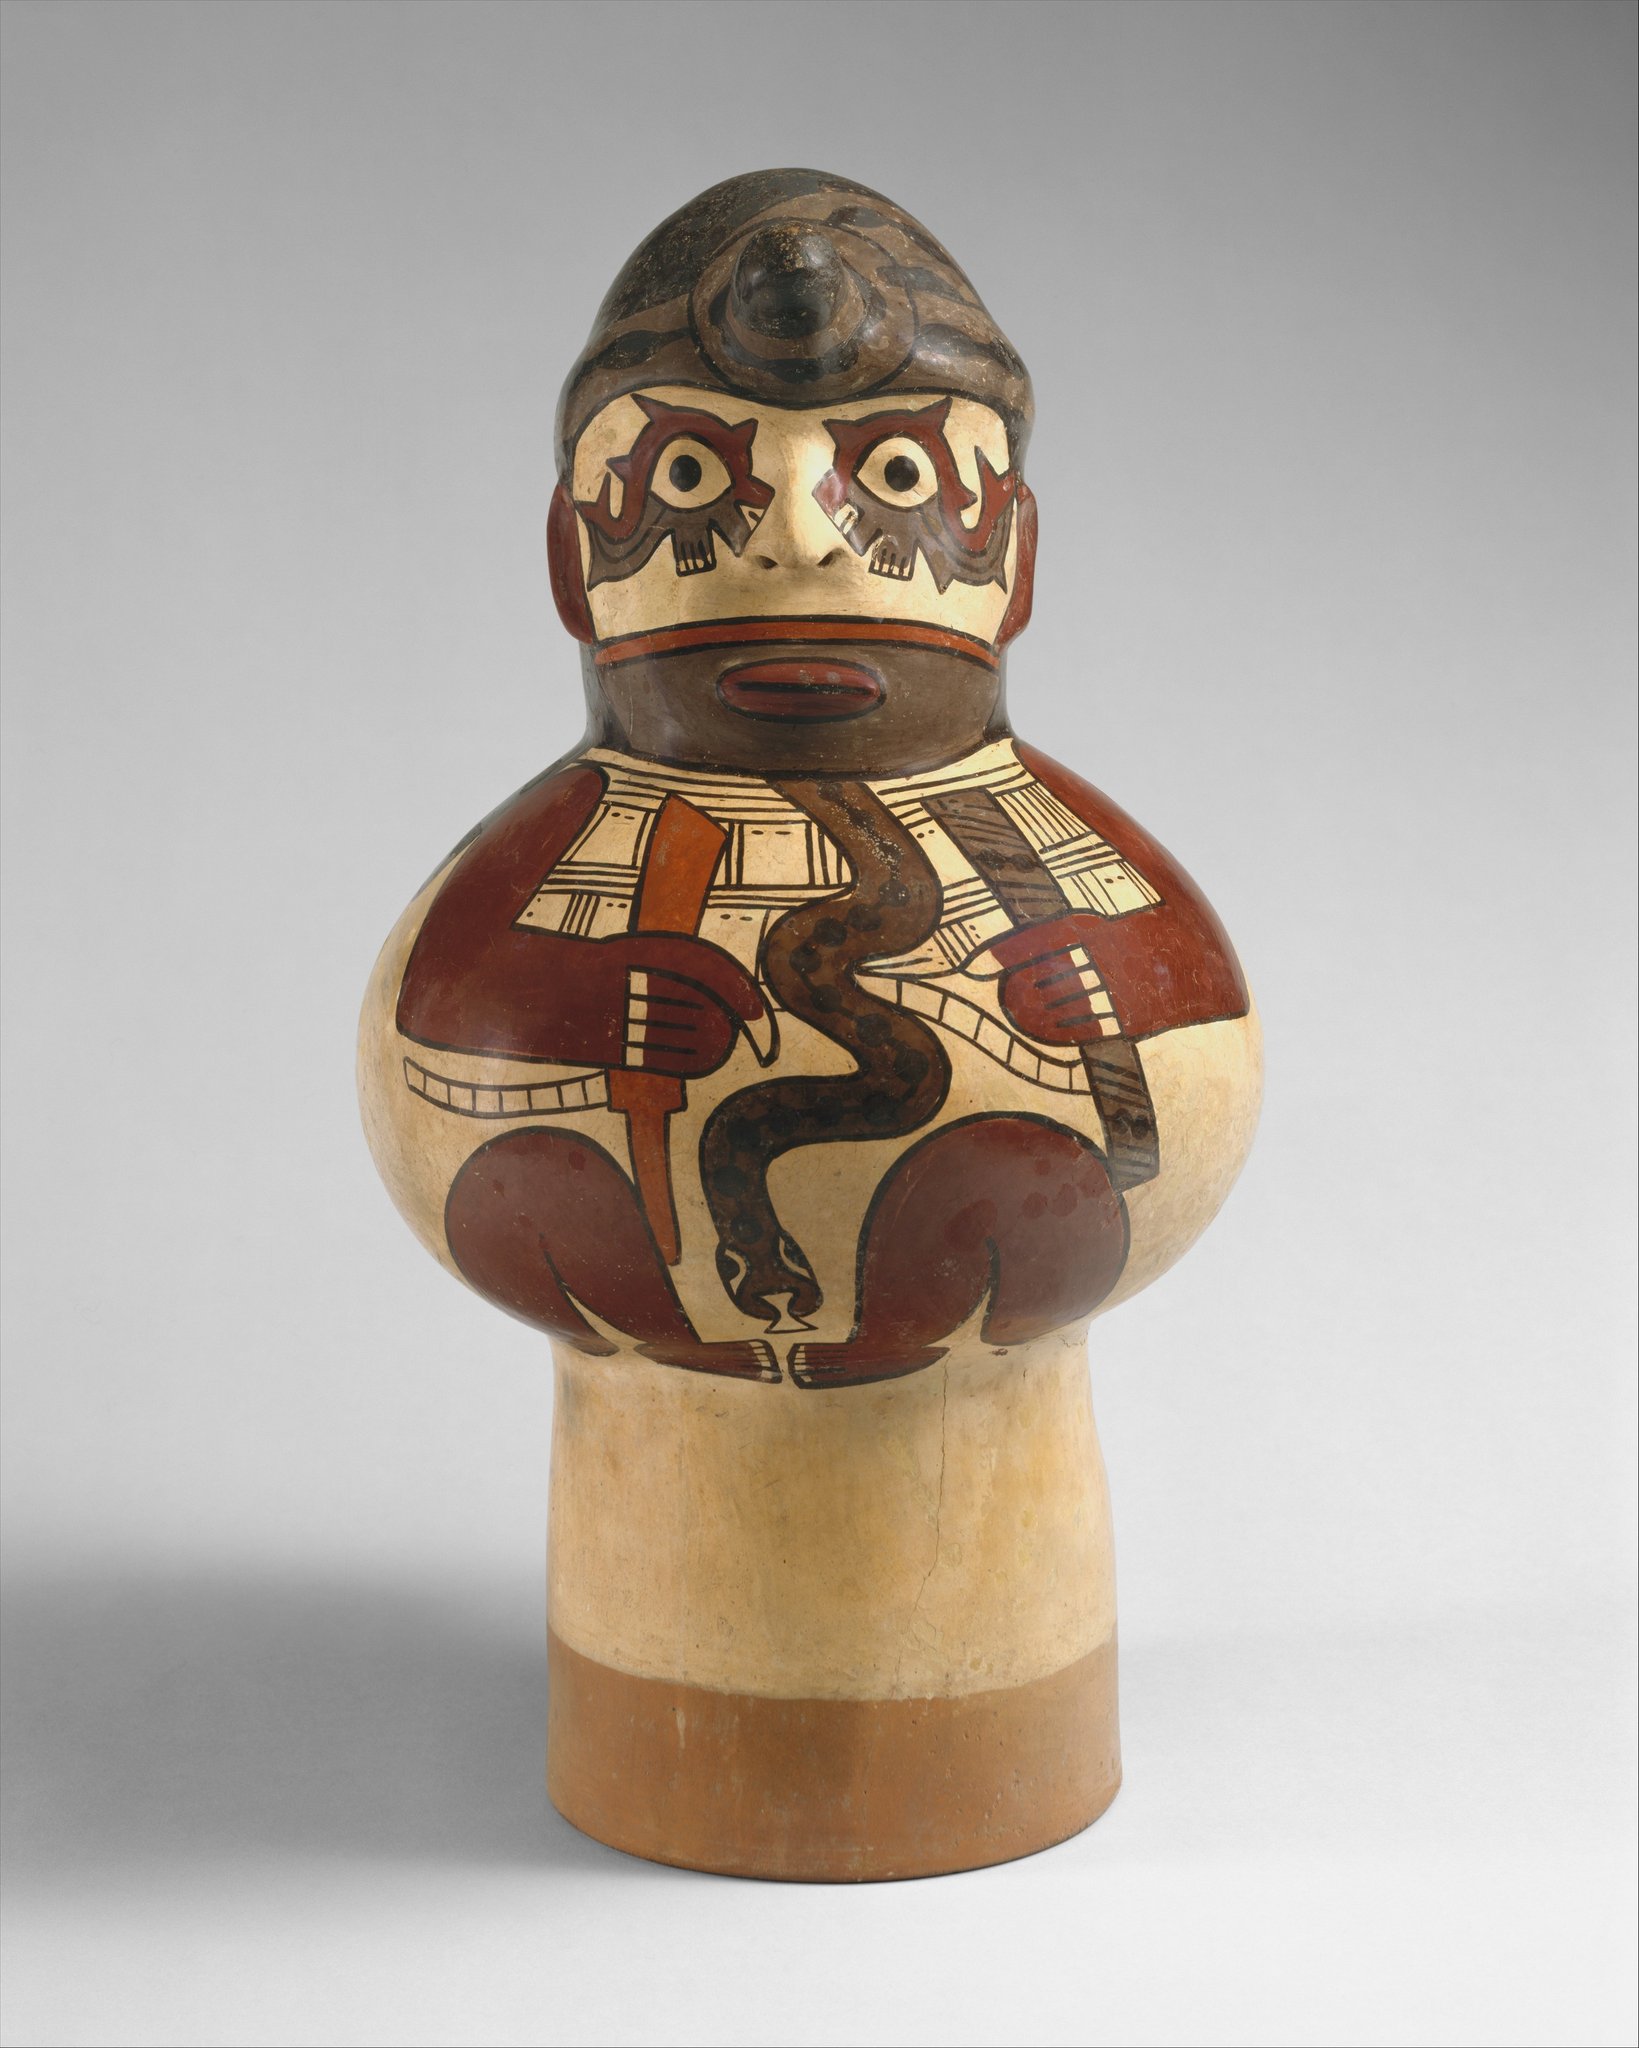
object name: drum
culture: nasca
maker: nasca artist(s)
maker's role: artist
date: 100-400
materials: ceramic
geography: peru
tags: human figures,snakes